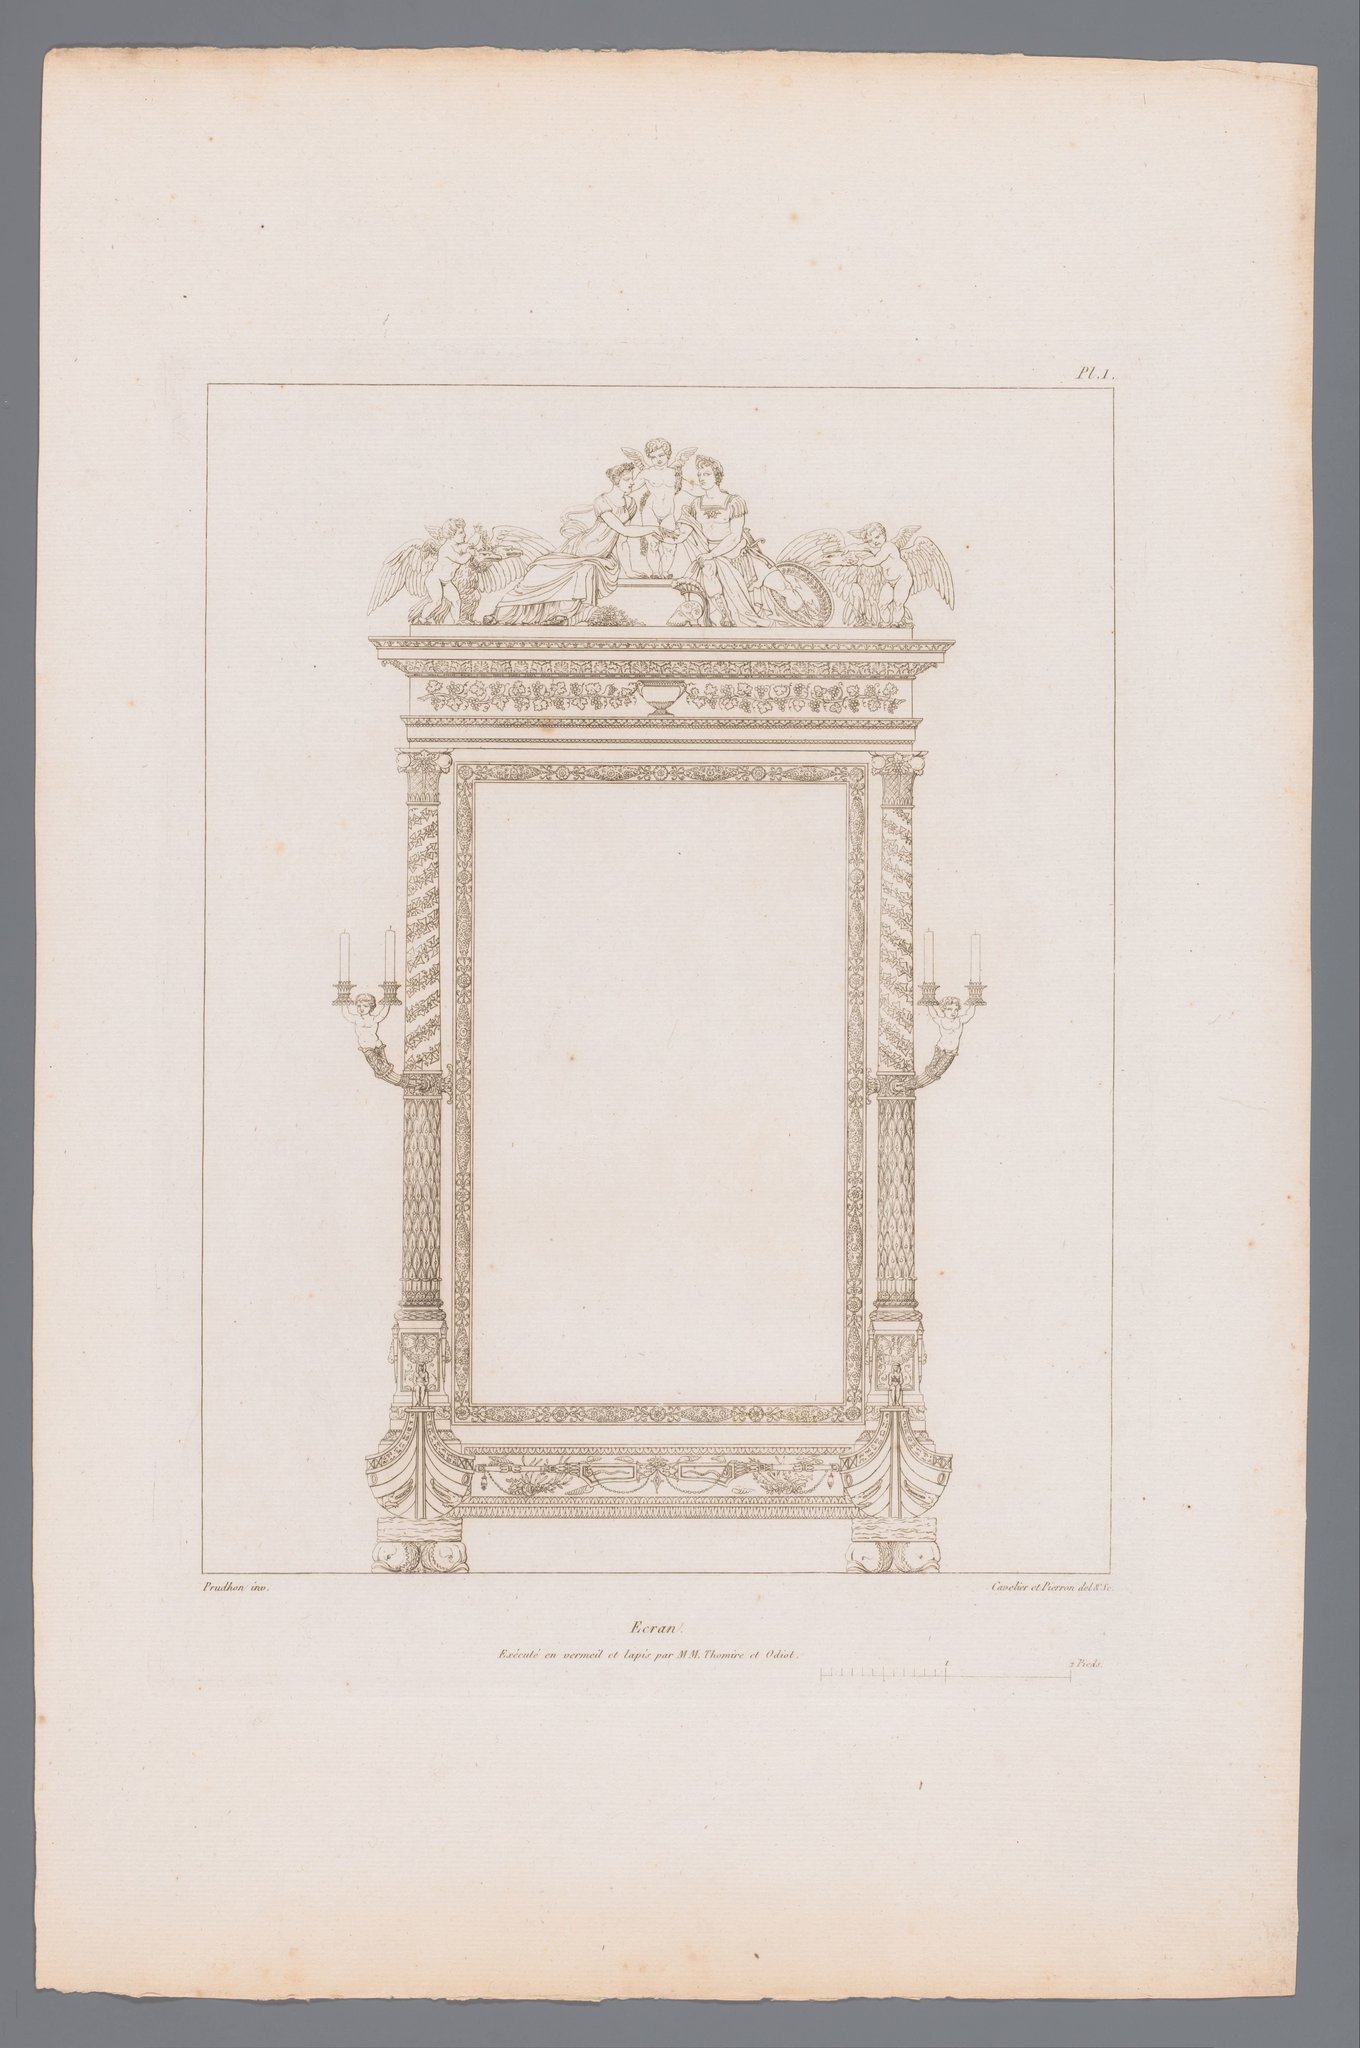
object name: print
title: Meubels geschonken aan Marie Louise van Oostenrijk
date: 1811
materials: paper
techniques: etching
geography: paris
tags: mars and venus as lovers, (story of) hymen(aeus), screen, folding screen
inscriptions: collector's mark: Lugt 2228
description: Maakt deel uit van een omslag met prenten met meubels naar ontwerp van Pierre Prud'hon. Deze meubels werden aangeboden aan Marie Louise van Oostenrijk ter gelegenheid van de geboorte van haar zoon Frans Karel Jozef Napoleon II Bonaparte.